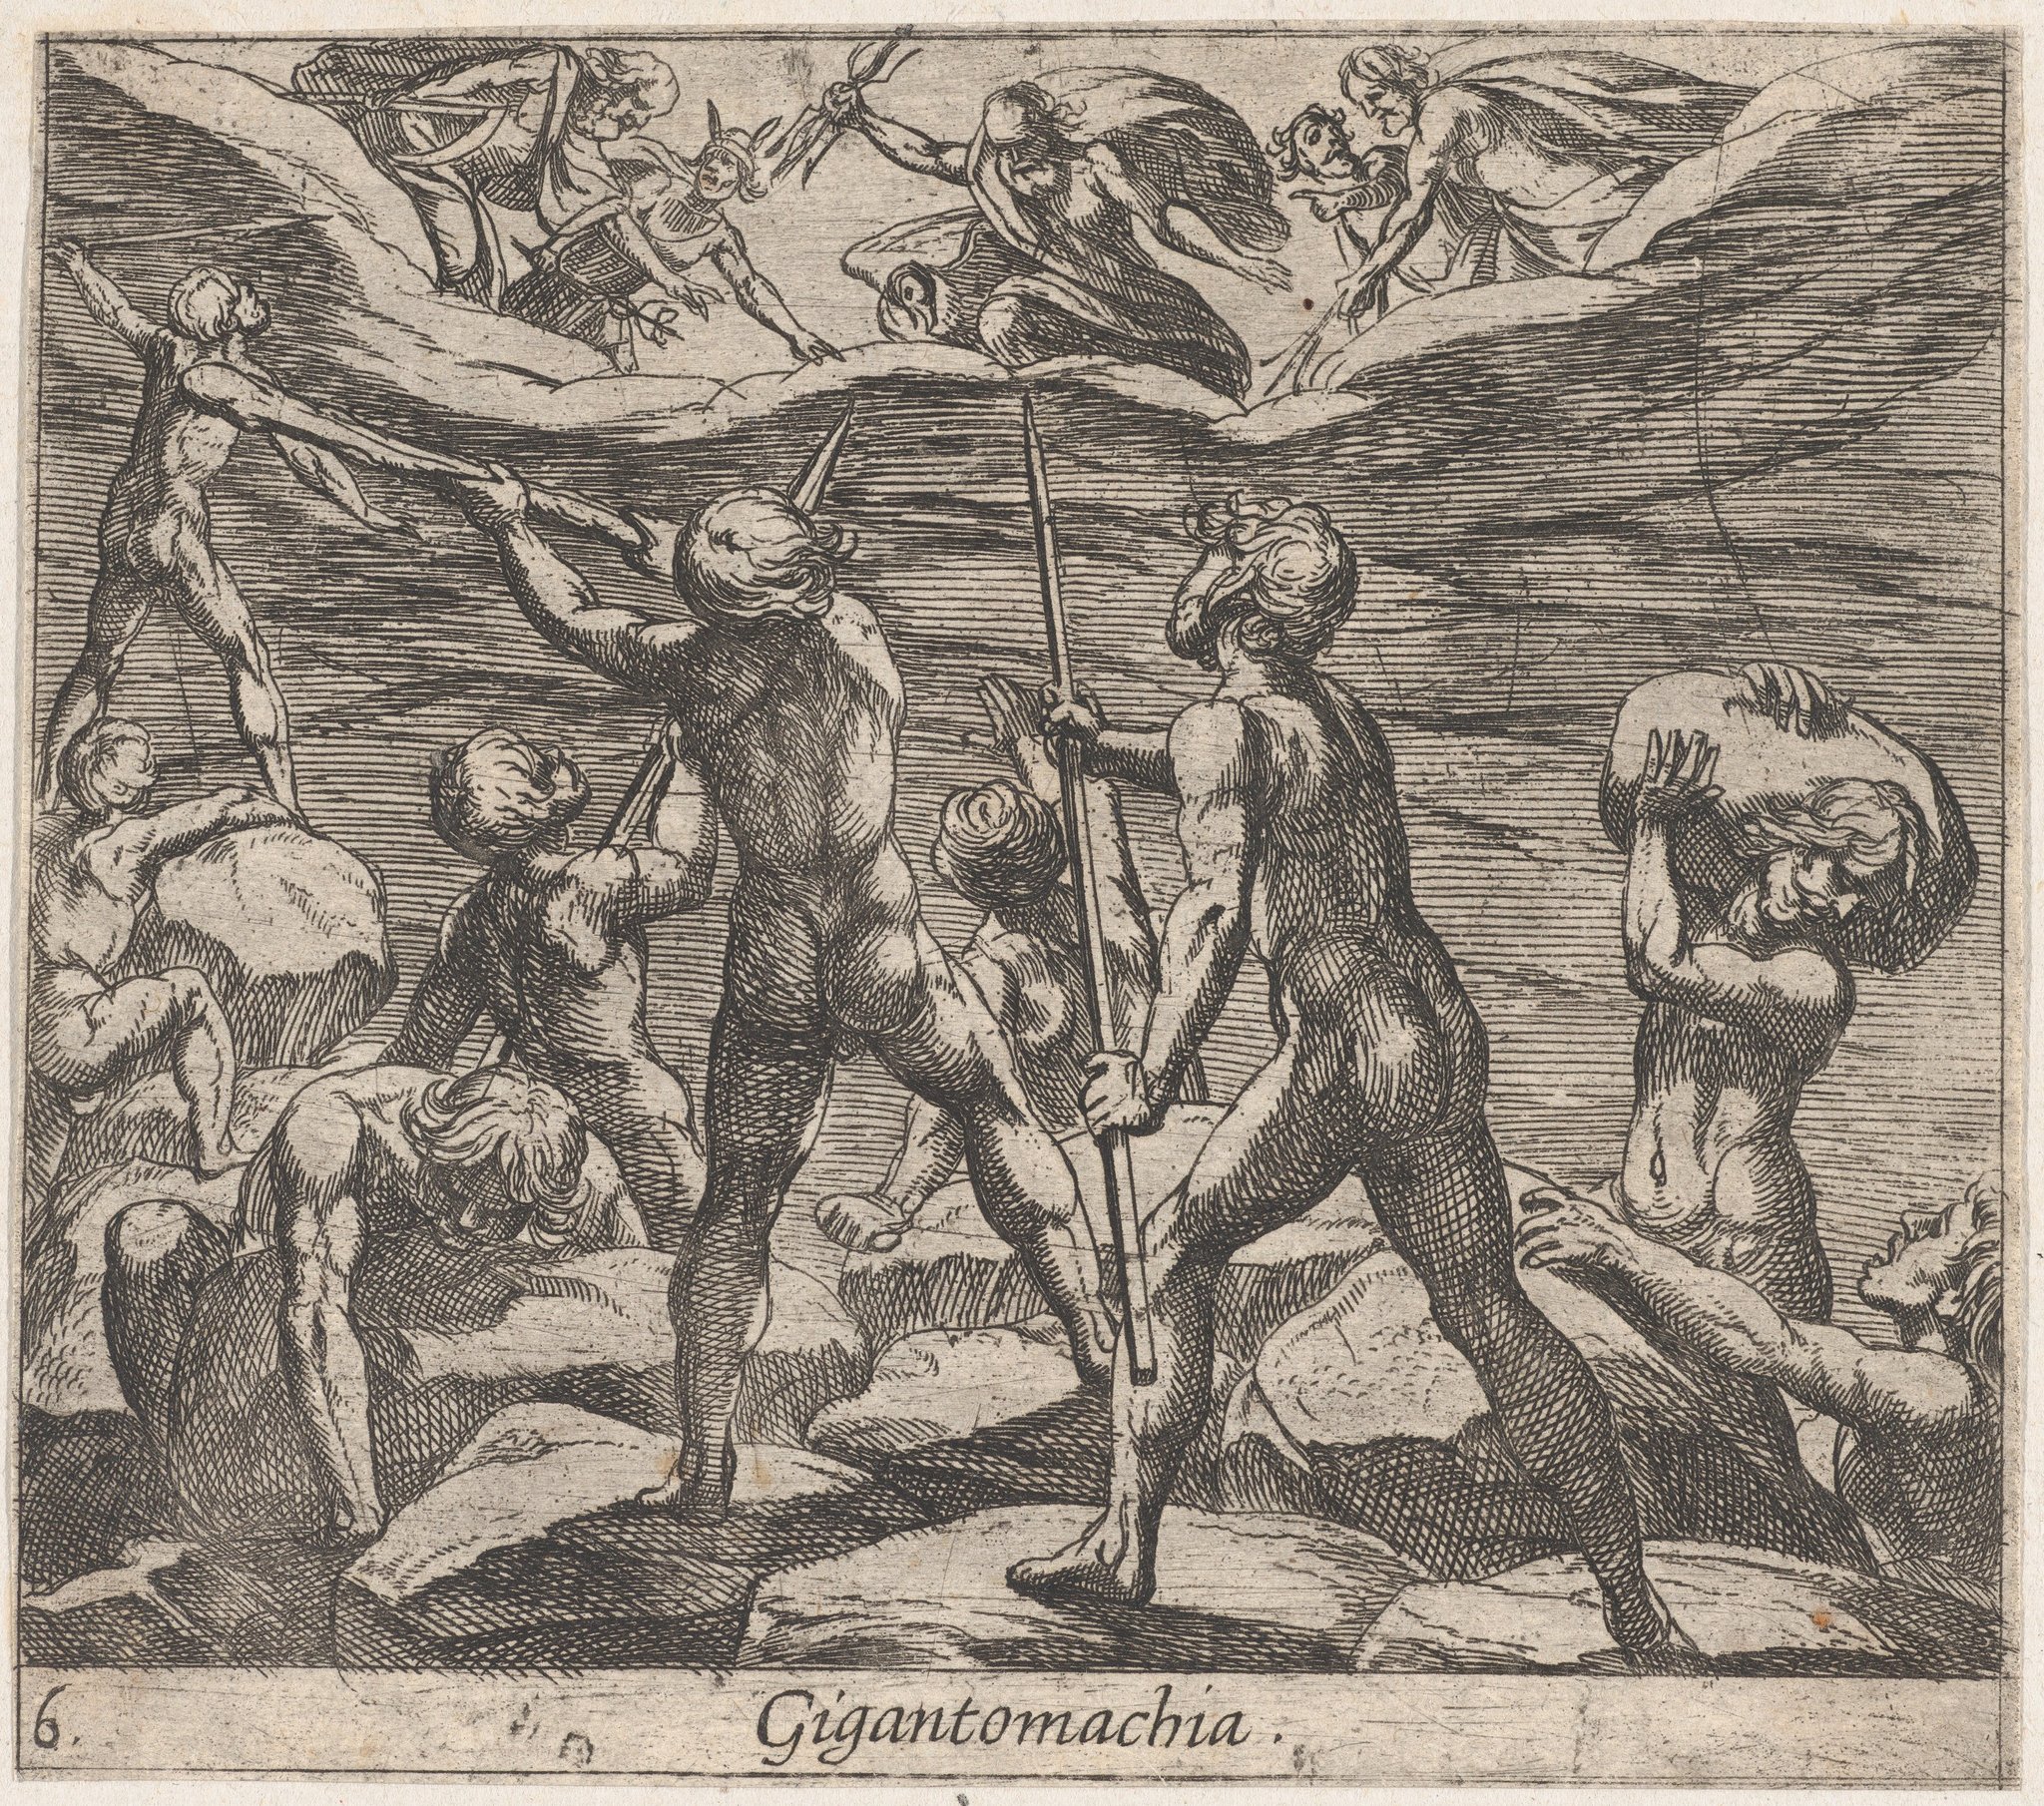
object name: print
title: Plate 6: The Giants Attempting to Storm Olympus (Gigantomachia), from Ovid's 'Metamorphoses'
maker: antonio tempesta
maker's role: artist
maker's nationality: italian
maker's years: 1555-1630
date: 1606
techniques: etching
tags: male nudes